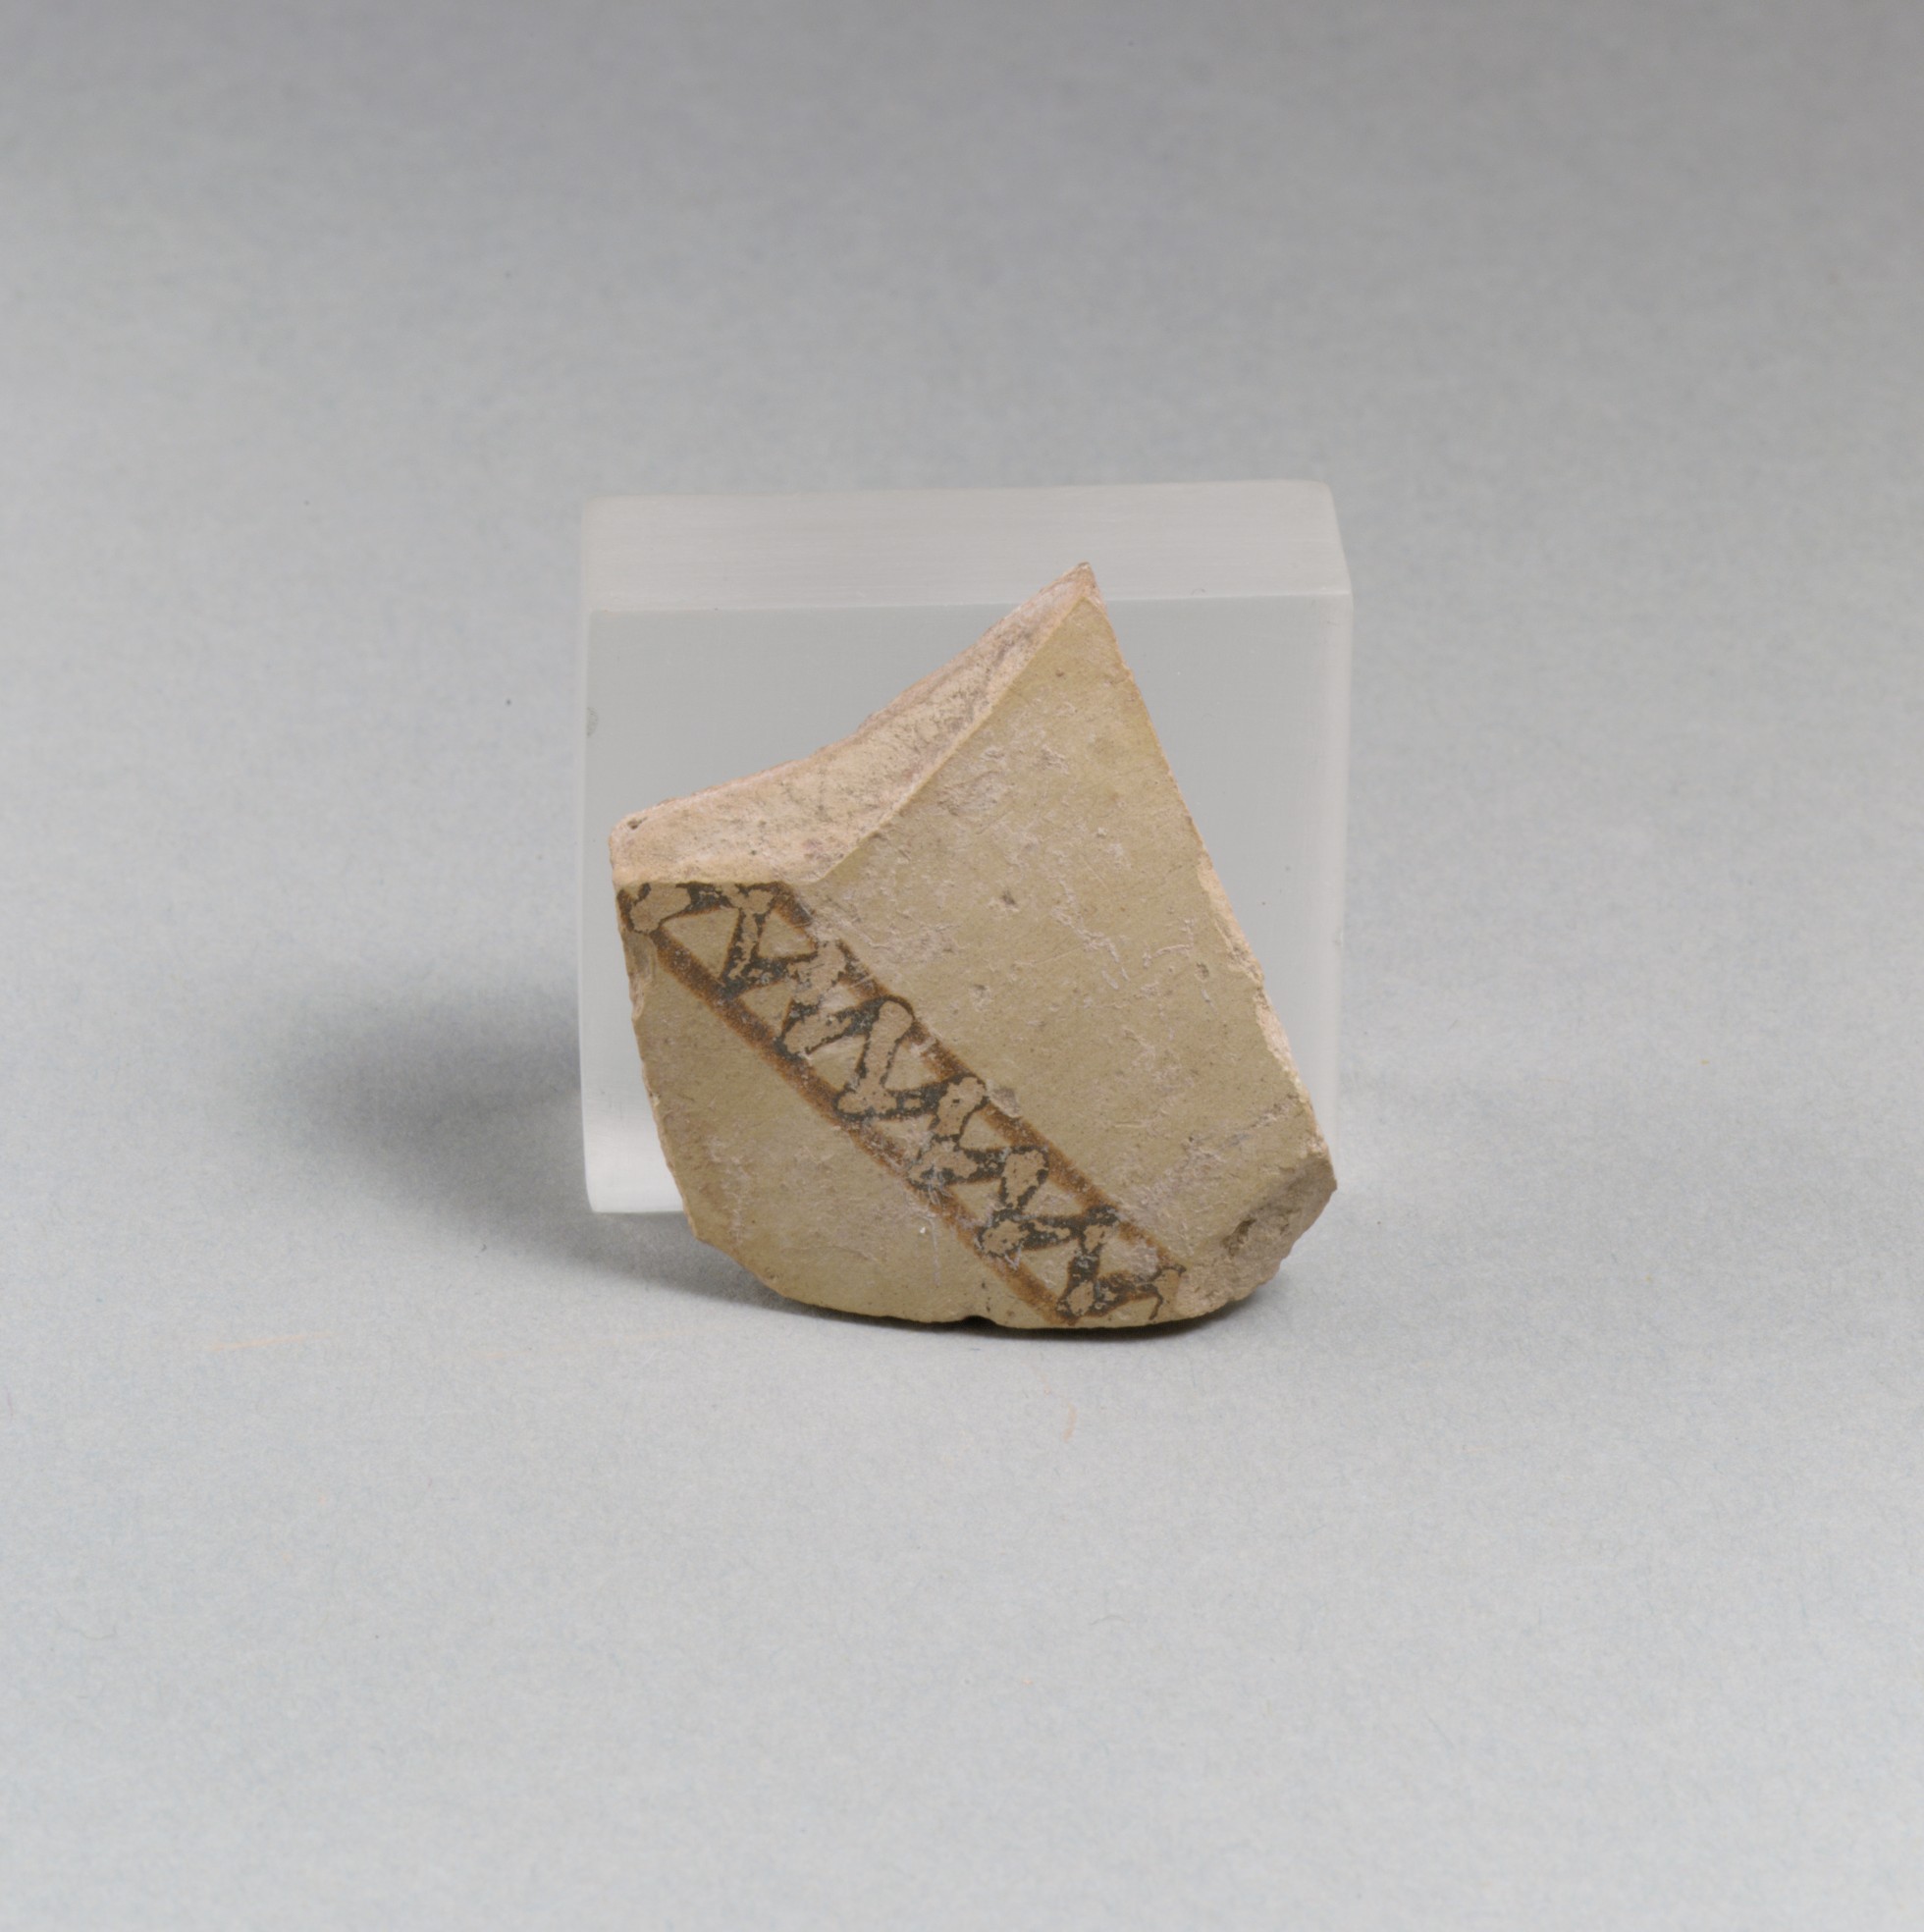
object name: vase fragment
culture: mycenaean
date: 1400-1300 BCE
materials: terracotta